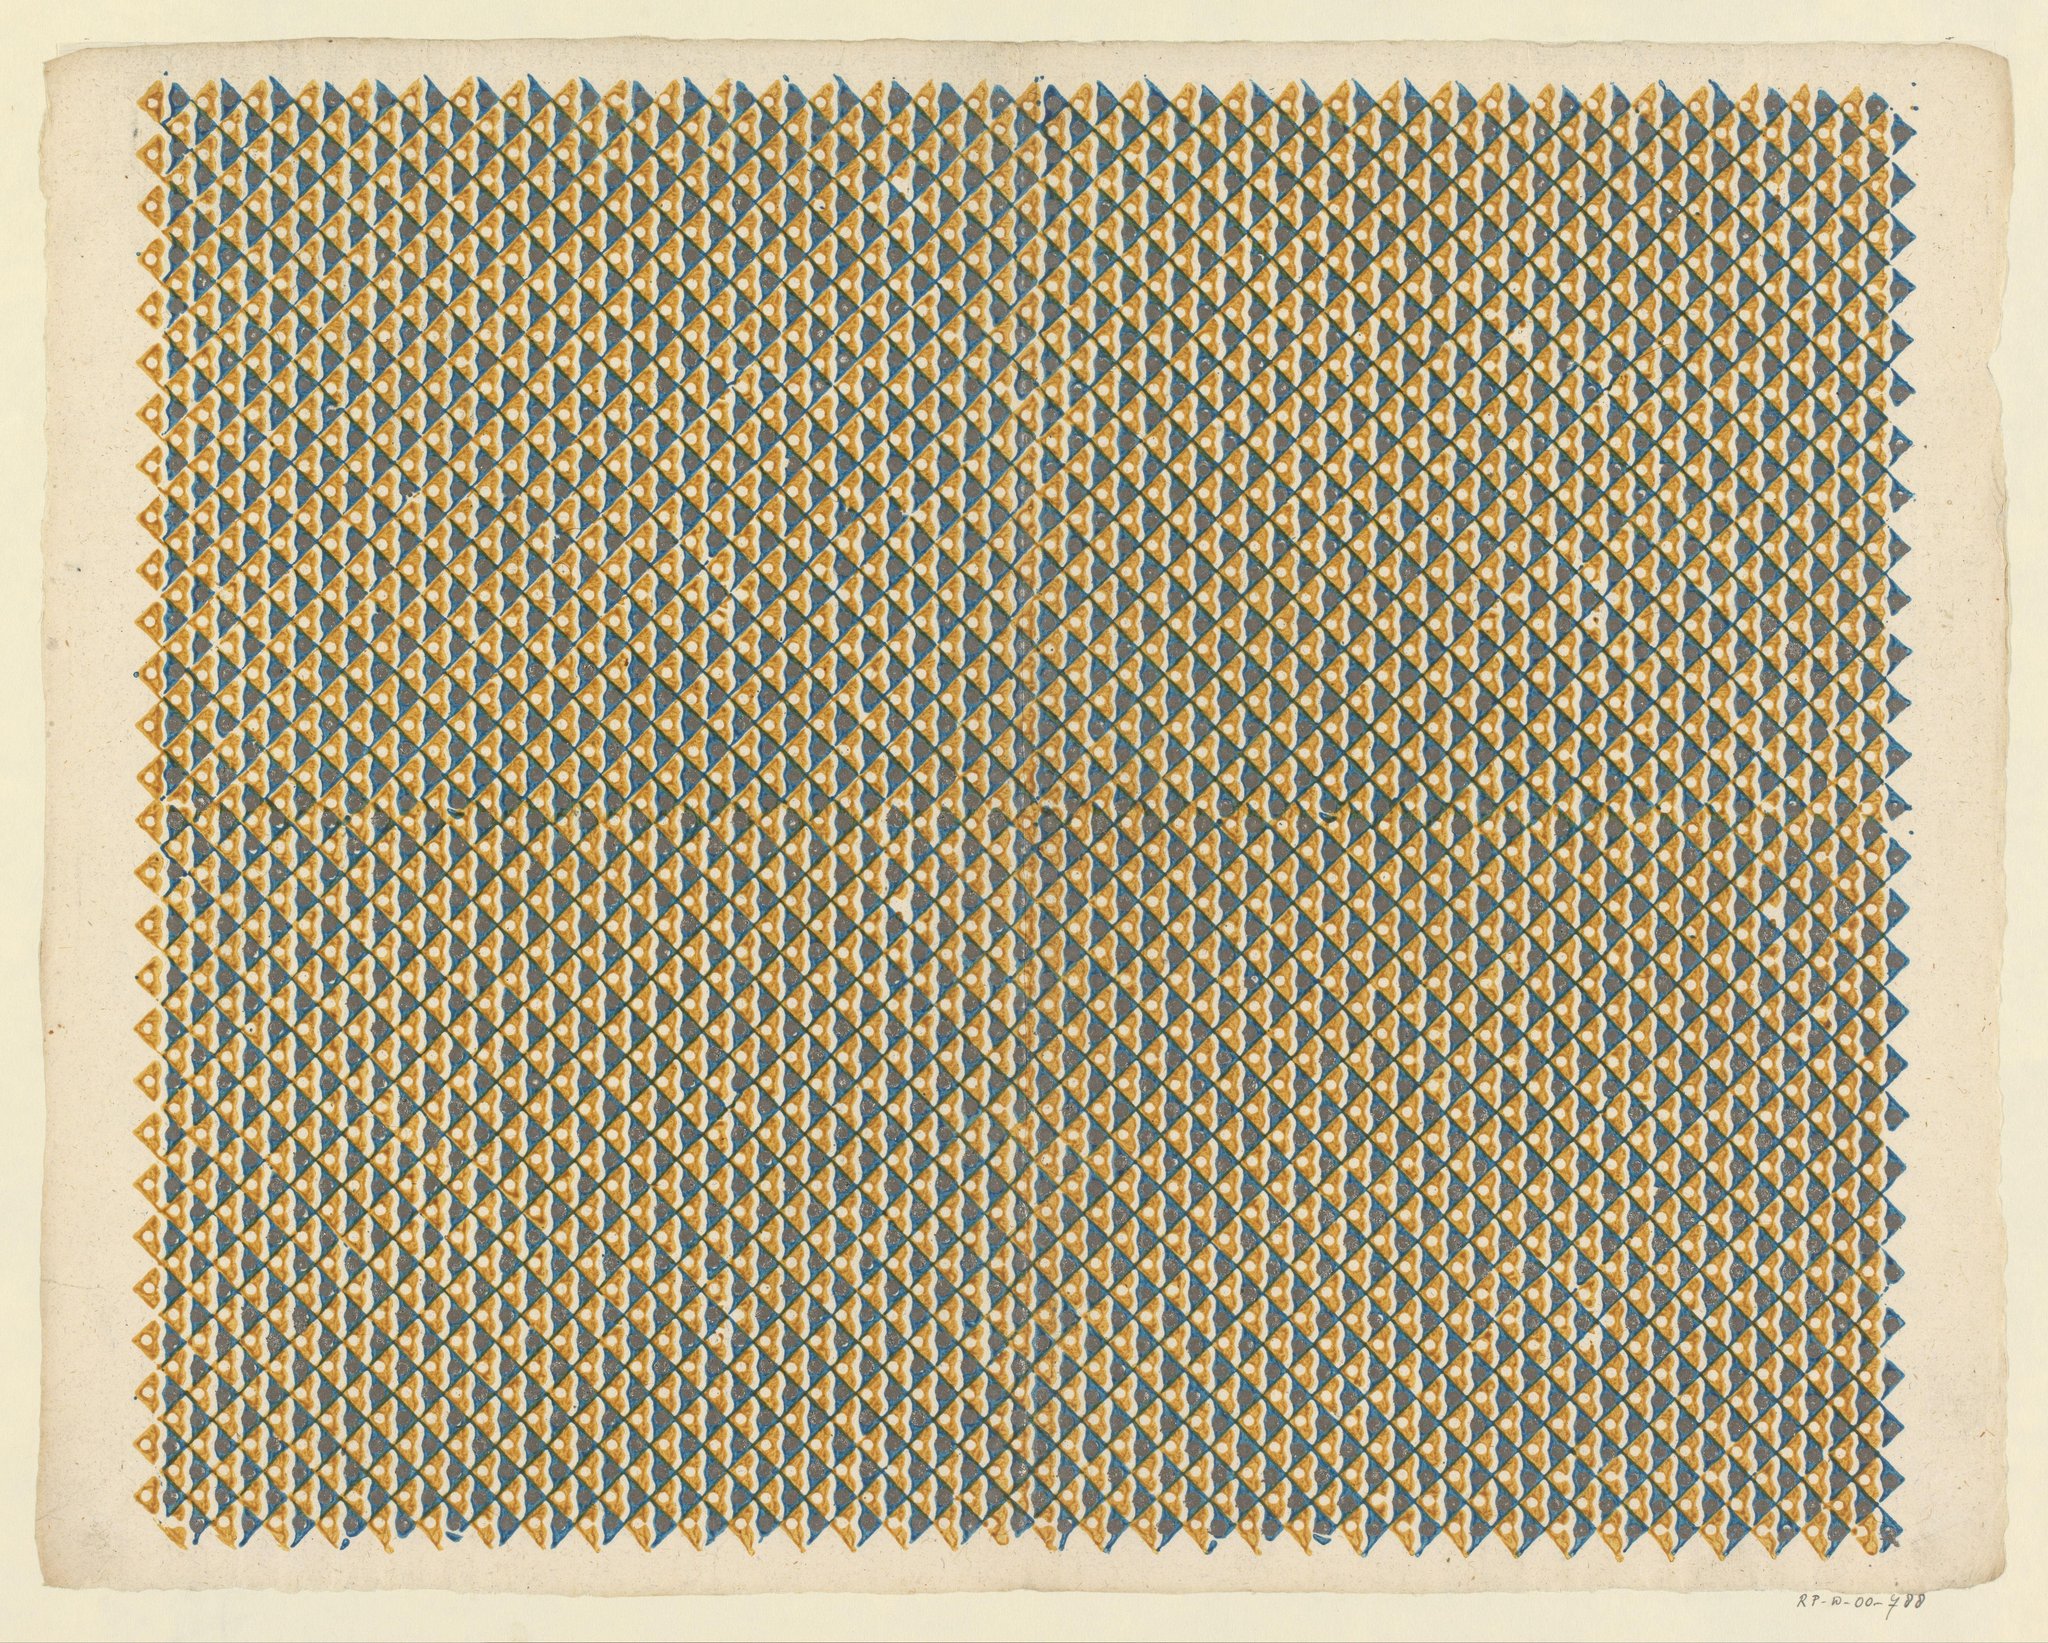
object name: printed paper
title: Blad met schubbenpatroon van driehoeken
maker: Anonymous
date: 1750-1950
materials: paper, paint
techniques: printing block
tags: ornament ~ geometric motifs